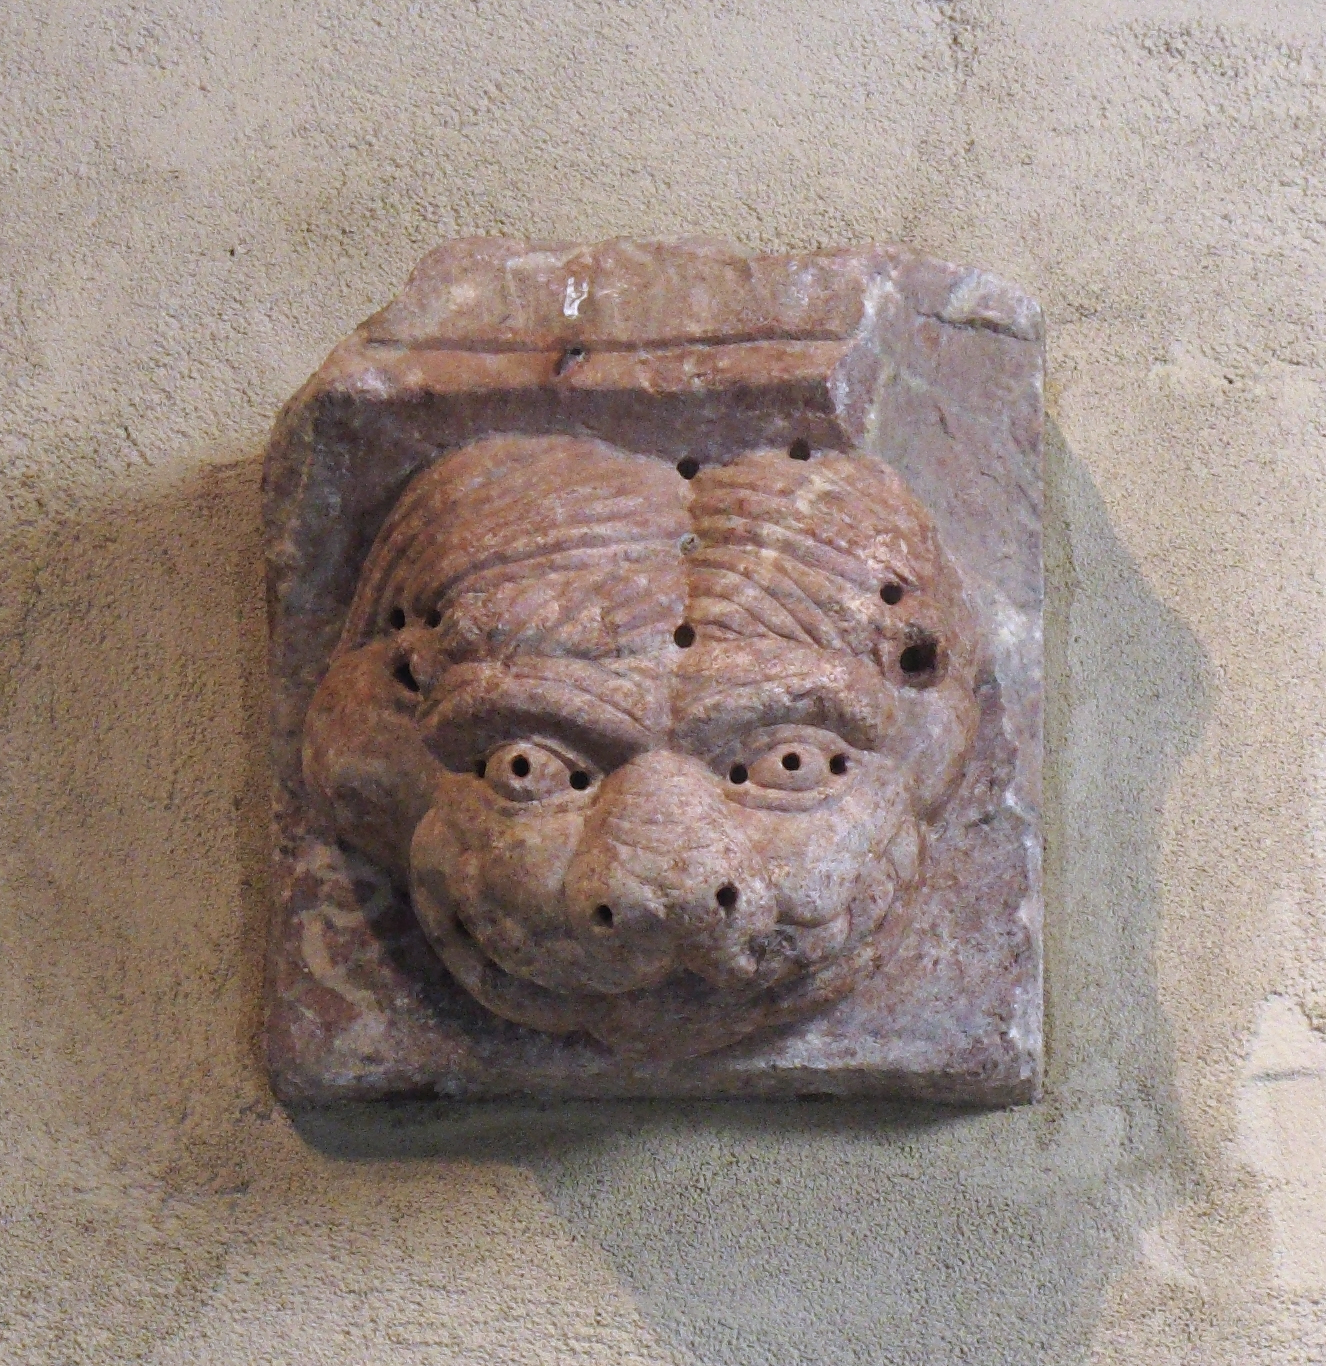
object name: corbel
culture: catalan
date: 1130-1140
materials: marble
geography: france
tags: animals